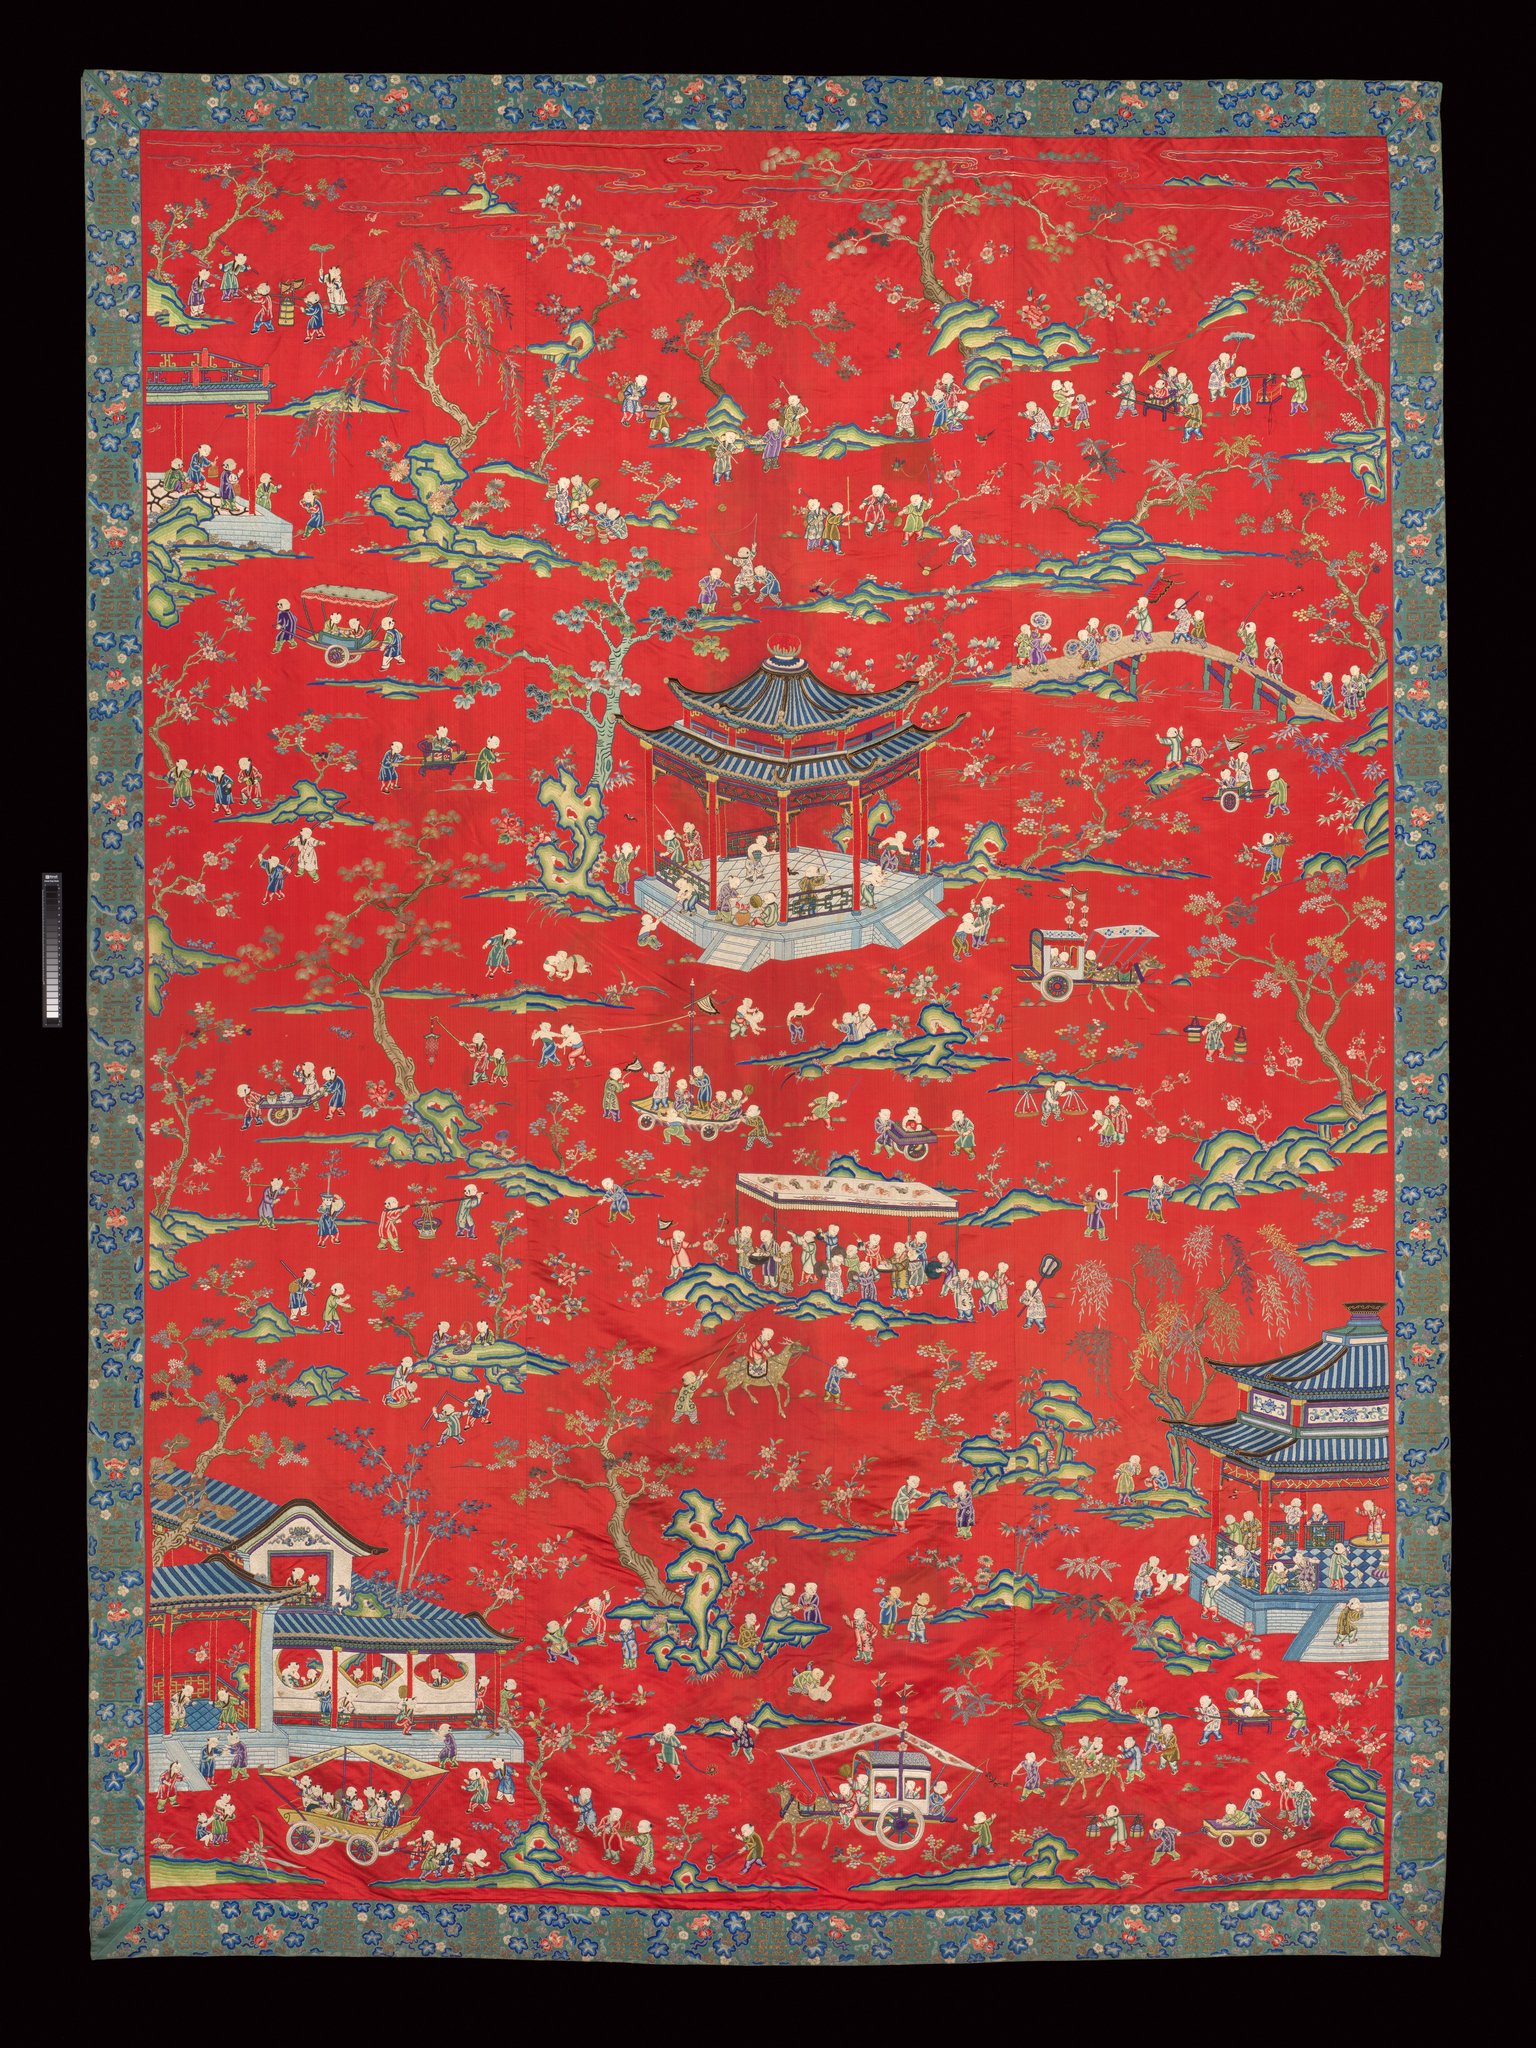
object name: hanging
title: Hanging with children at play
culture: chinese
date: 1801-1900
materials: metal thread, silk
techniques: embroidery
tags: buildings,houses,carriages